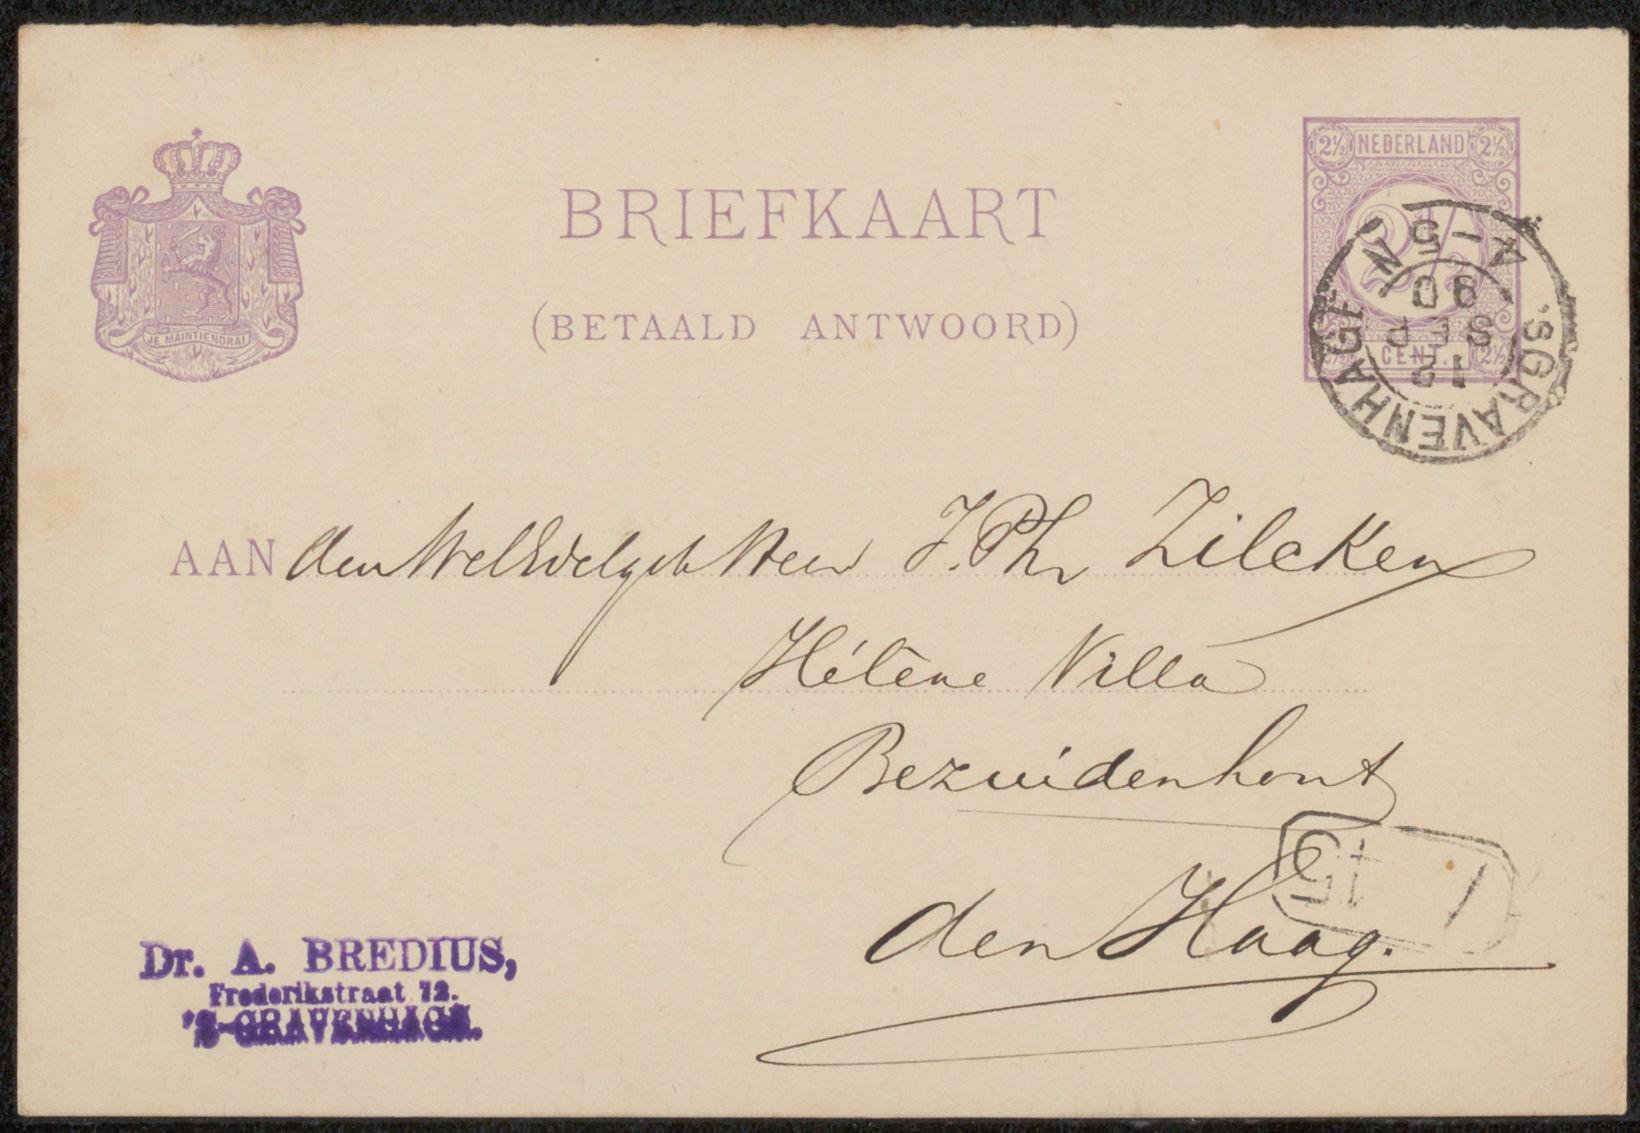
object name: postcard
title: Briefkaart aan Philip Zilcken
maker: abraham bredius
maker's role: kunsthistoricus, museumdirecteur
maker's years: 1855-1946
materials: cardboard, ink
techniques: pen, writing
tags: painter, draughtsman, philip zilcken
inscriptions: address: ‘Dr. A. BREDIUS,/ Frederikstraat 72./ 'S-GRAVENHAGE.’, collector's mark: ‘RPK’